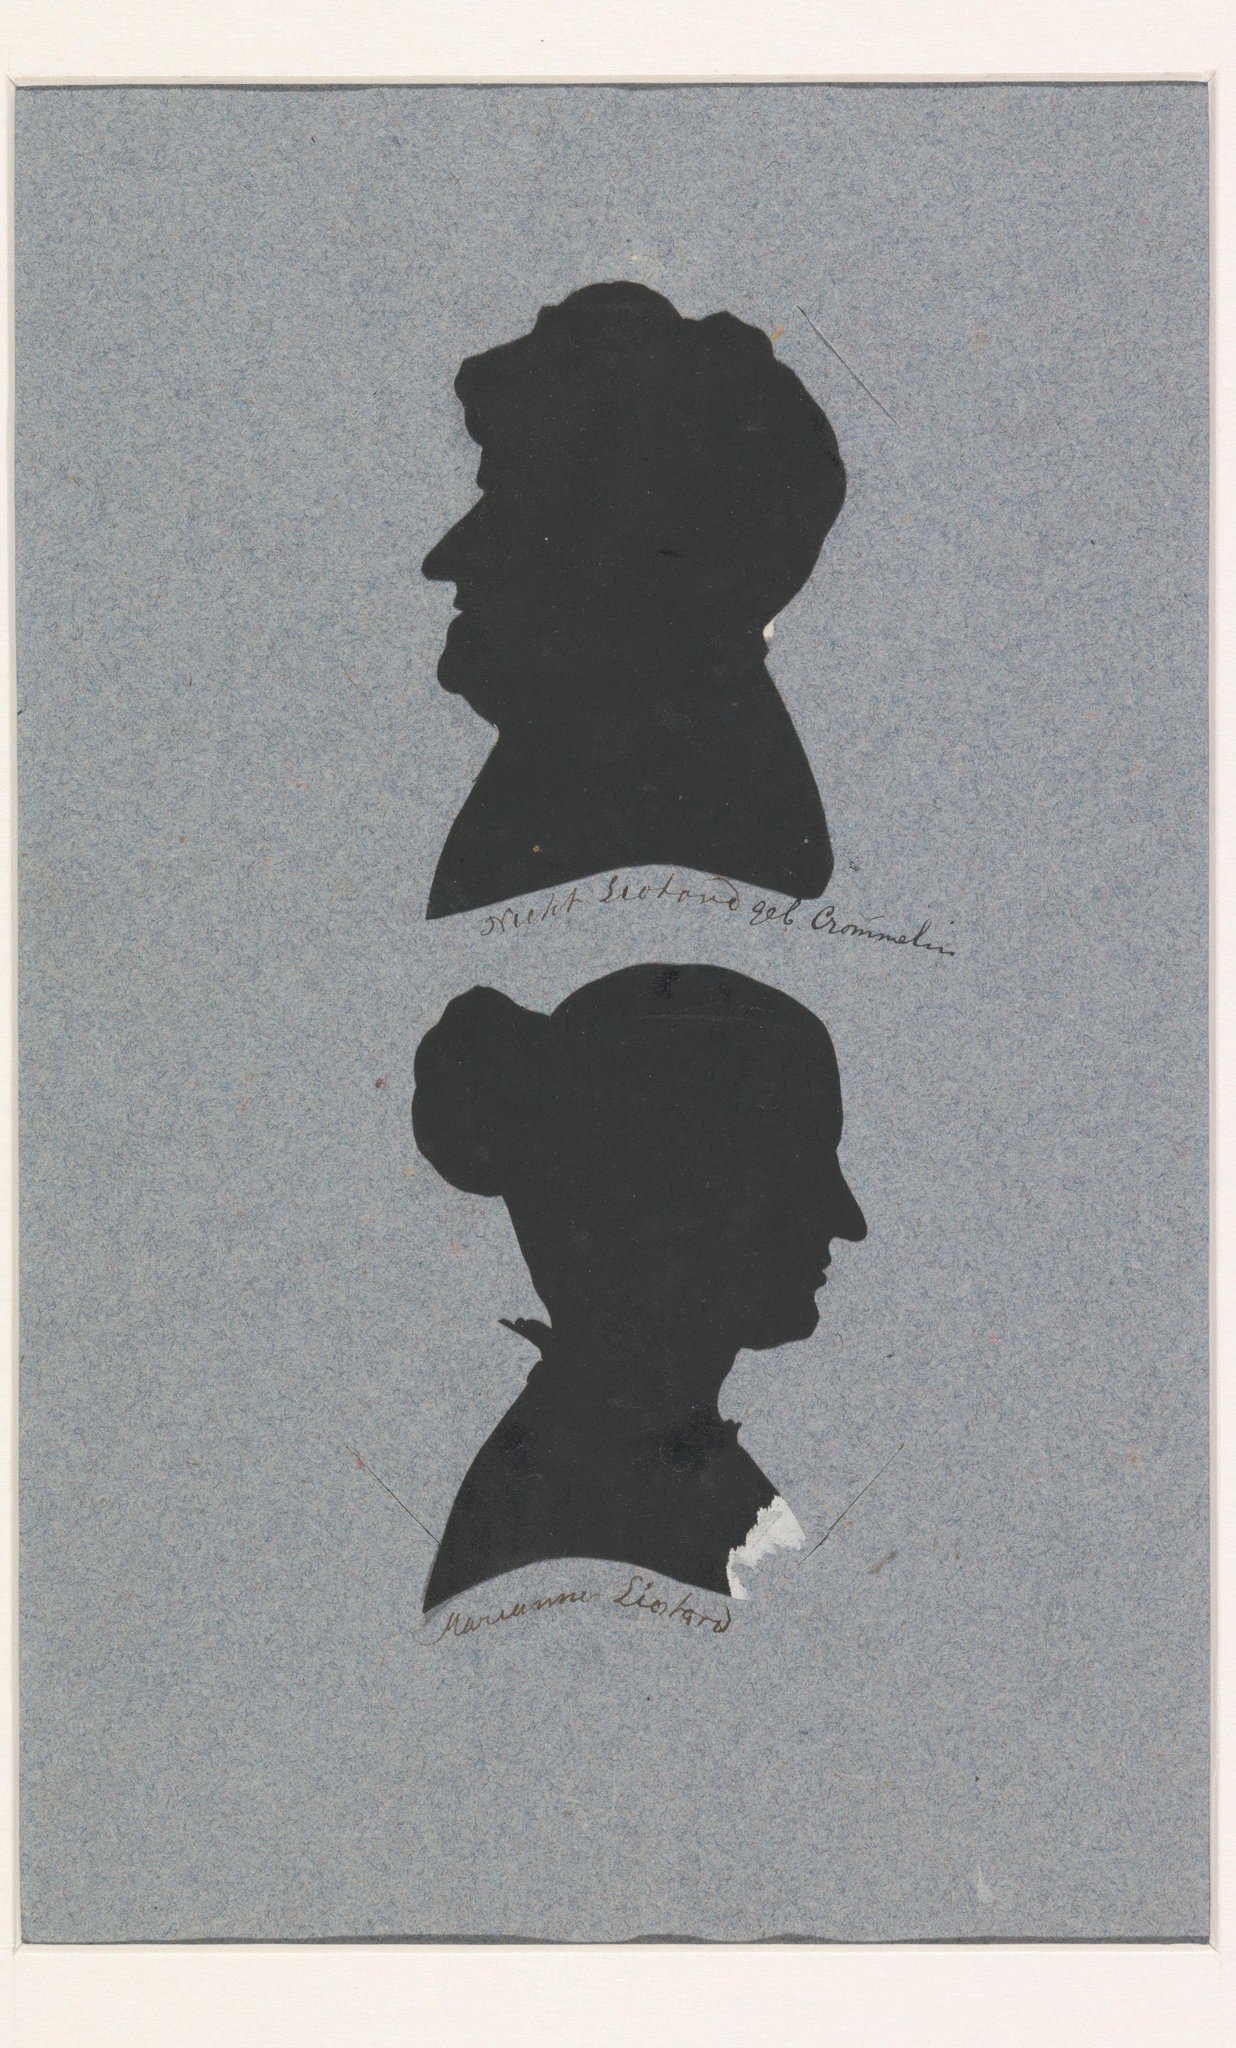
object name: cut paper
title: Silhouet van Johanna Suzanna Liotard-Crommelin en Marianne Liotard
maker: Anonymous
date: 1800-1900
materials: paper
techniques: brush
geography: netherlands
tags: amsterdam, historical person in a double portrait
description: Silhouet van Johanna Suzanna Liotard-Crommelin (1769-1841) en Marianne Liotard (1798-1873).